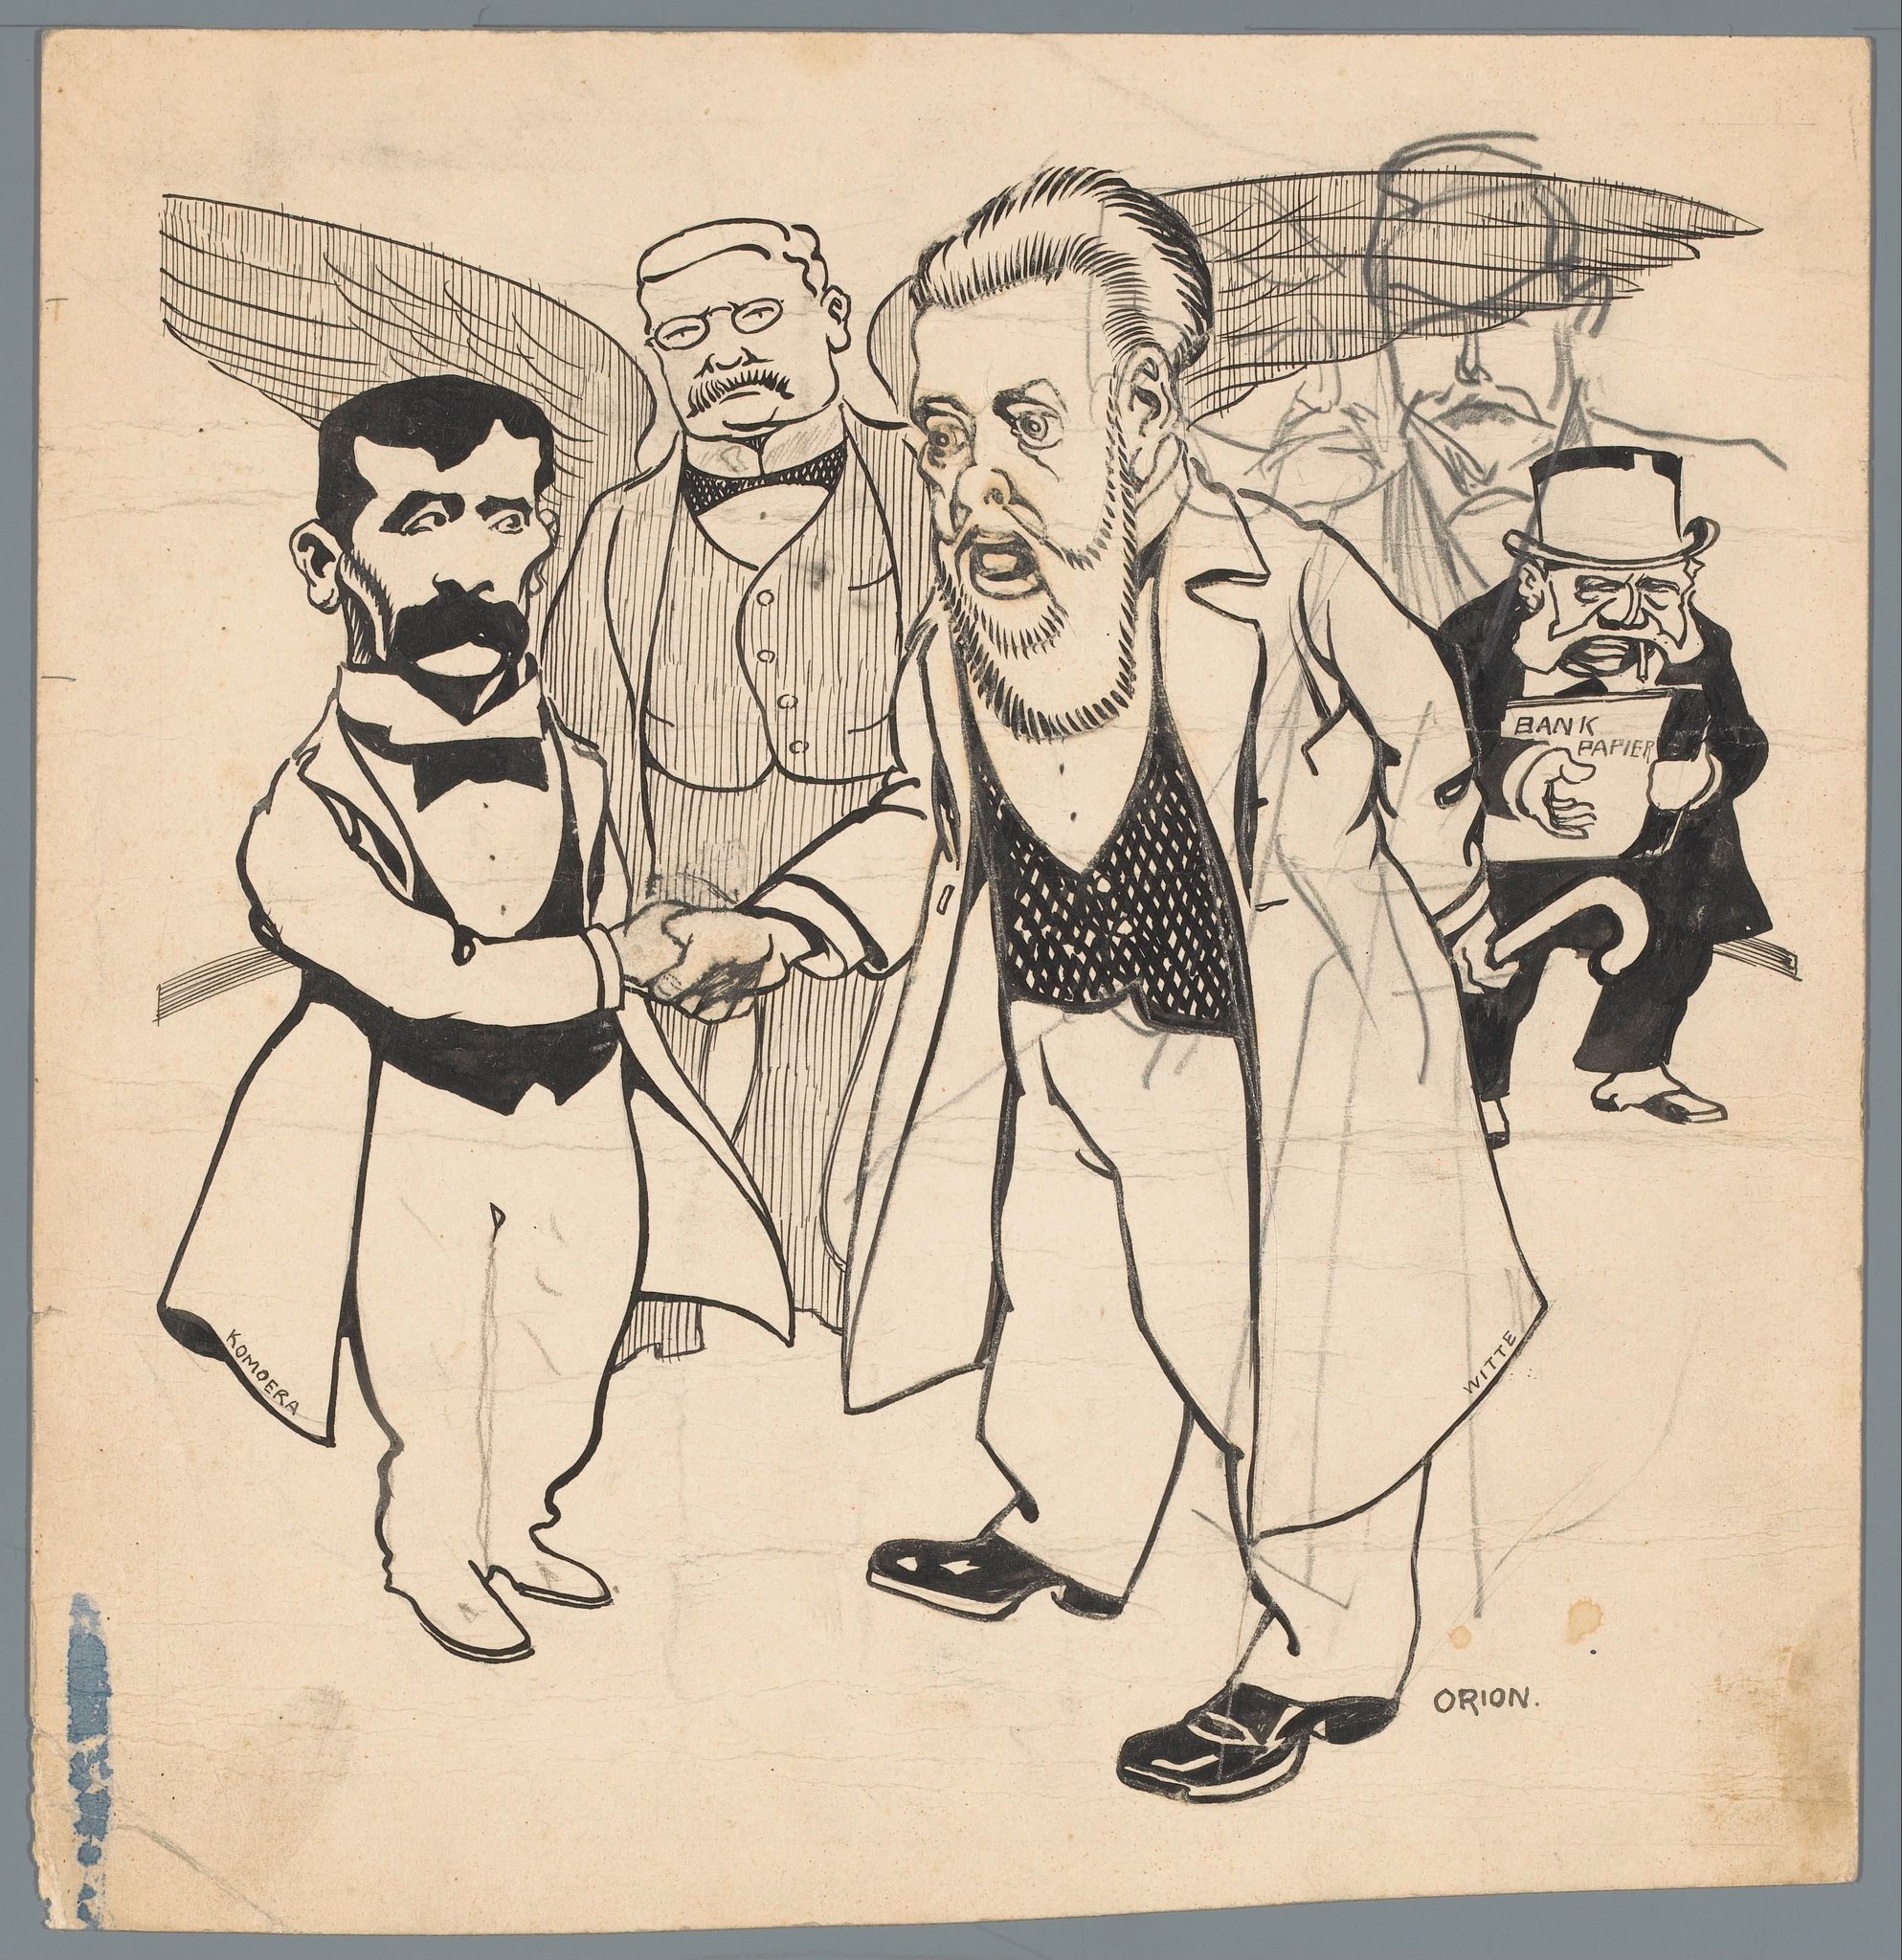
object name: drawing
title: Vrede tussen Japan en Rusland in 1905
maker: patricq kroon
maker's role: draughtsman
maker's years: 1862-1941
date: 1905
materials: ink, paper, pencil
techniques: brush, pen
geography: netherlands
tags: new york (city), politician, signing of peace treaty, concluding the peace, political caricatures and satires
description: Vrede gesloten tussen Japan en Rusland met het Verdrag van Portsmouth in 1905 waarmee een eind wordt gemaakt aan de Russisch-Japanse Oorlog. Sergei Witte en Komura Jutarō schudden elkaar de hand, op de achtergrond kijkt Theodore Roosevelt als vredesengel toe. Ontwerp voor een politieke spotprent.